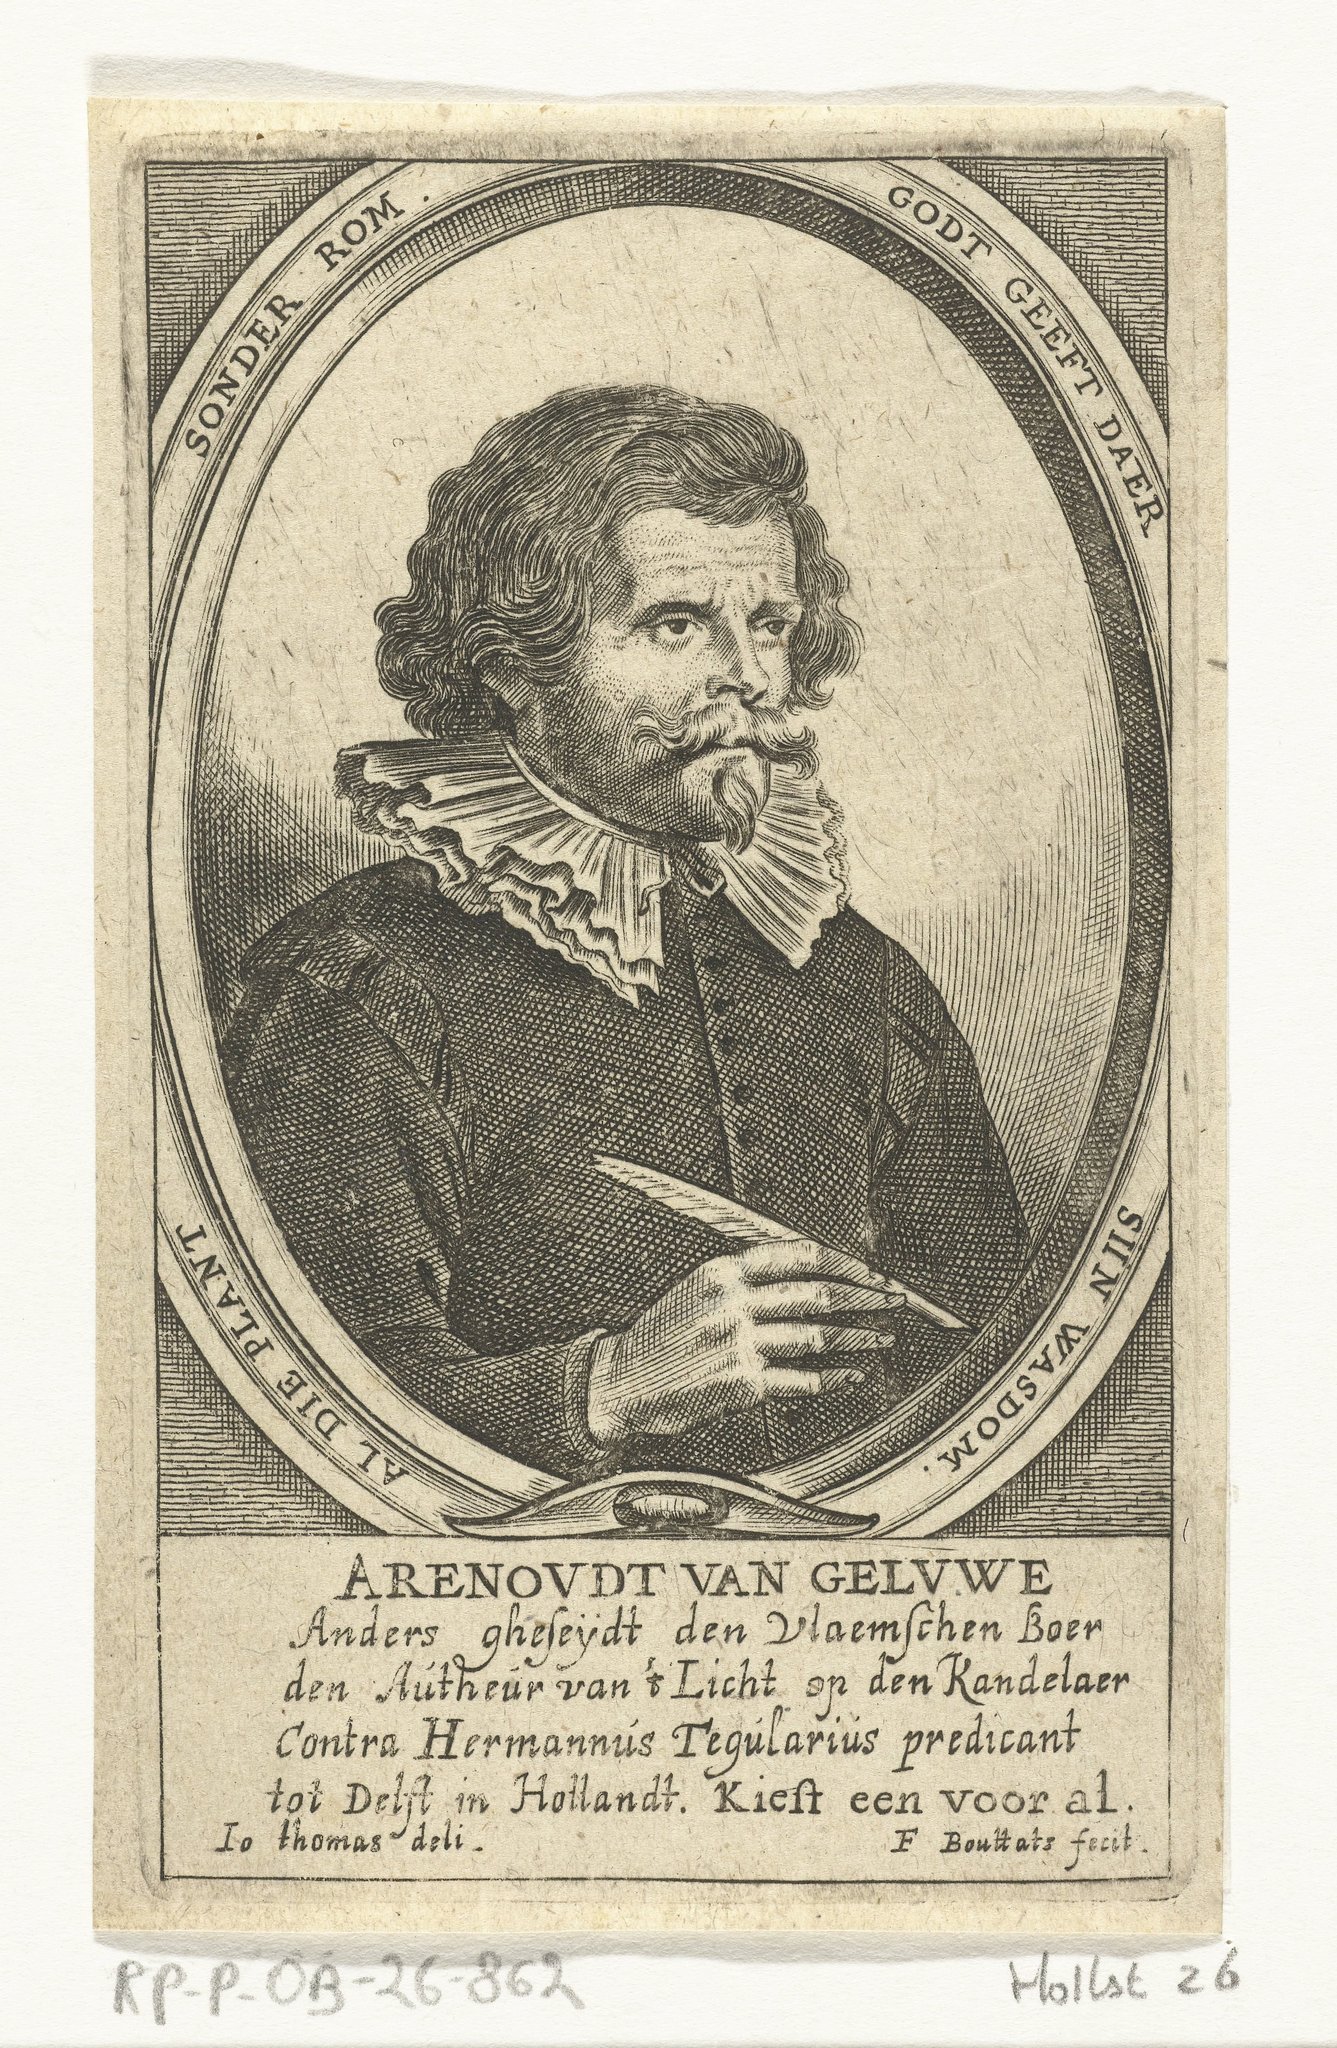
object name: print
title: Portret van Aernout van Geluwe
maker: frederik bouttats (i)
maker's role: artist, painter, print maker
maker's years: 1590-1661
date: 1627-1676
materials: paper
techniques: engraving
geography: antwerp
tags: schrijver, aernout van geluwe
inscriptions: collector's mark: Lugt 2228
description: Portret in een ovale lijst van Aernout van Geluwe, ook wel de 'Vlaamse Boer' genoemd. Buste naar rechts. Arnout houdt in zijn rechterhand een schrijfveer vast. De prent heeft een Nederlands onderschrift met de naam van de geportretteerde: 'Arenoudt van Geluwe. Anders gheseydt den Vlaemschen Boer, den autheur van't Licht op den Kandelaer contra Hermannus Tegularius predicant tot Delft in Hollandt. Kiest een voor al'.